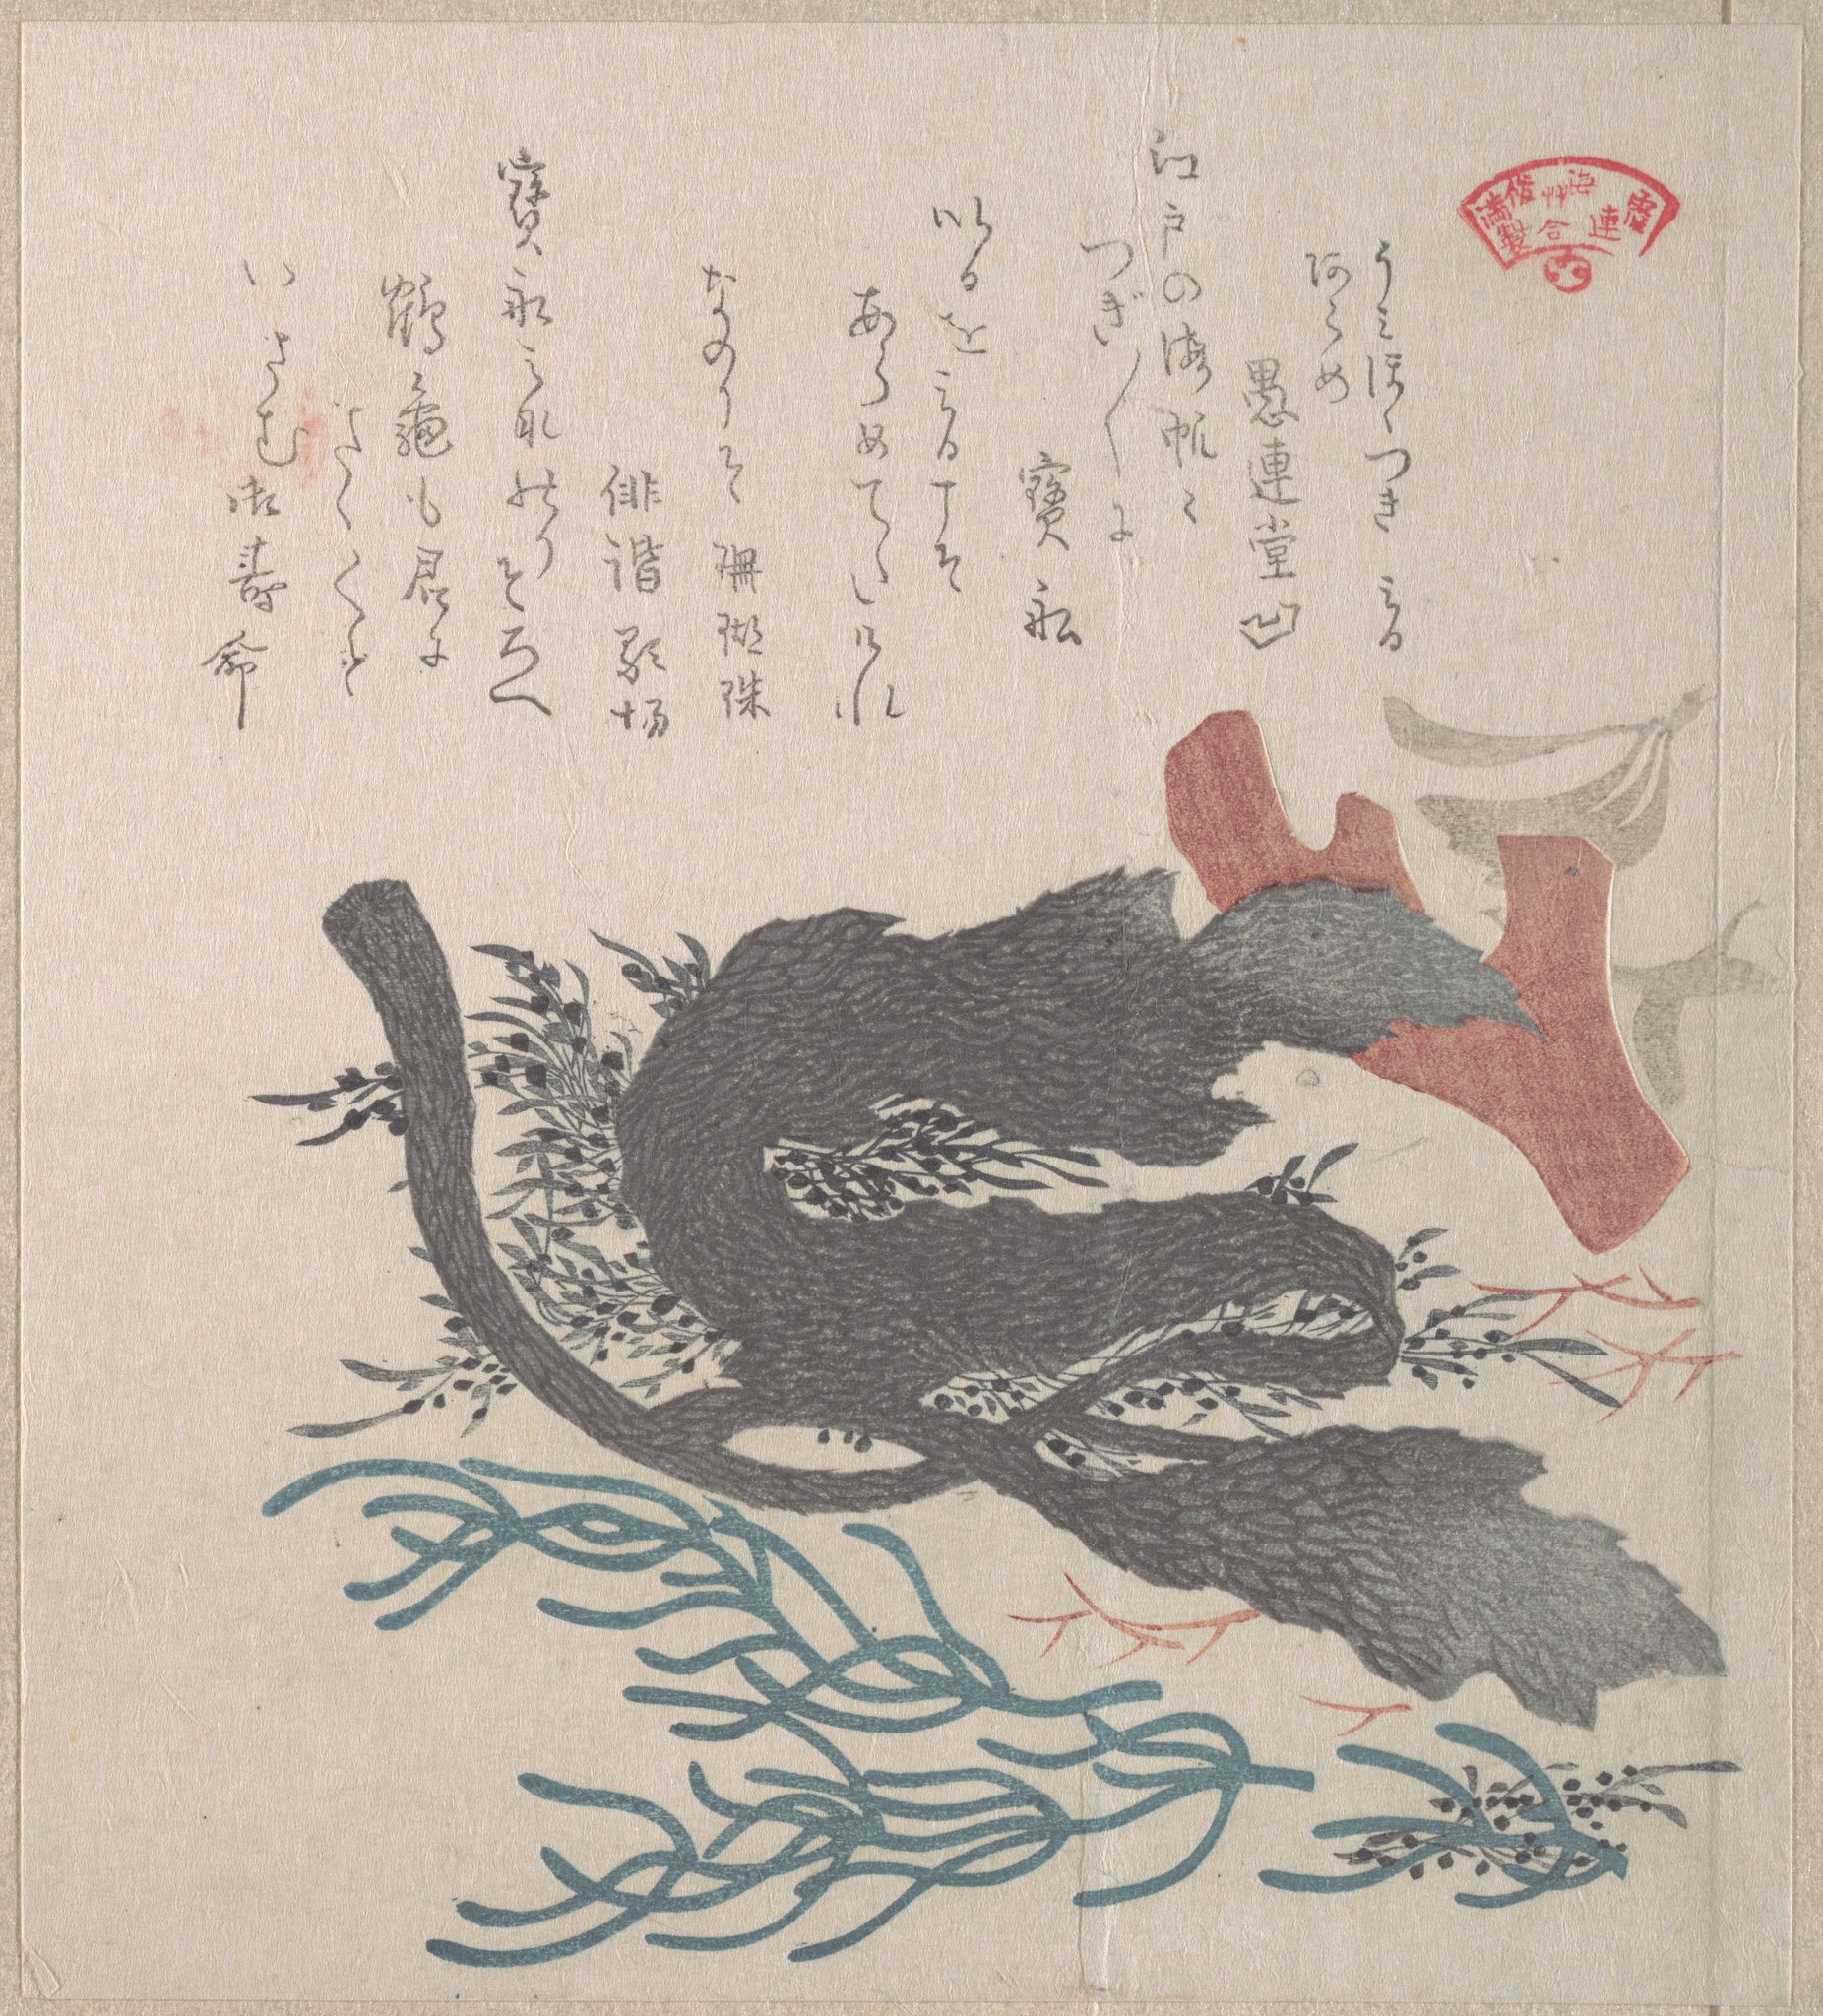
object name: print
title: Various Seaweed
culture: japanese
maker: kubo shunman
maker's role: artist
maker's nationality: japanese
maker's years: 1757-1820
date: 1801-1900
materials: ink, paper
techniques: surimono, woodblock print